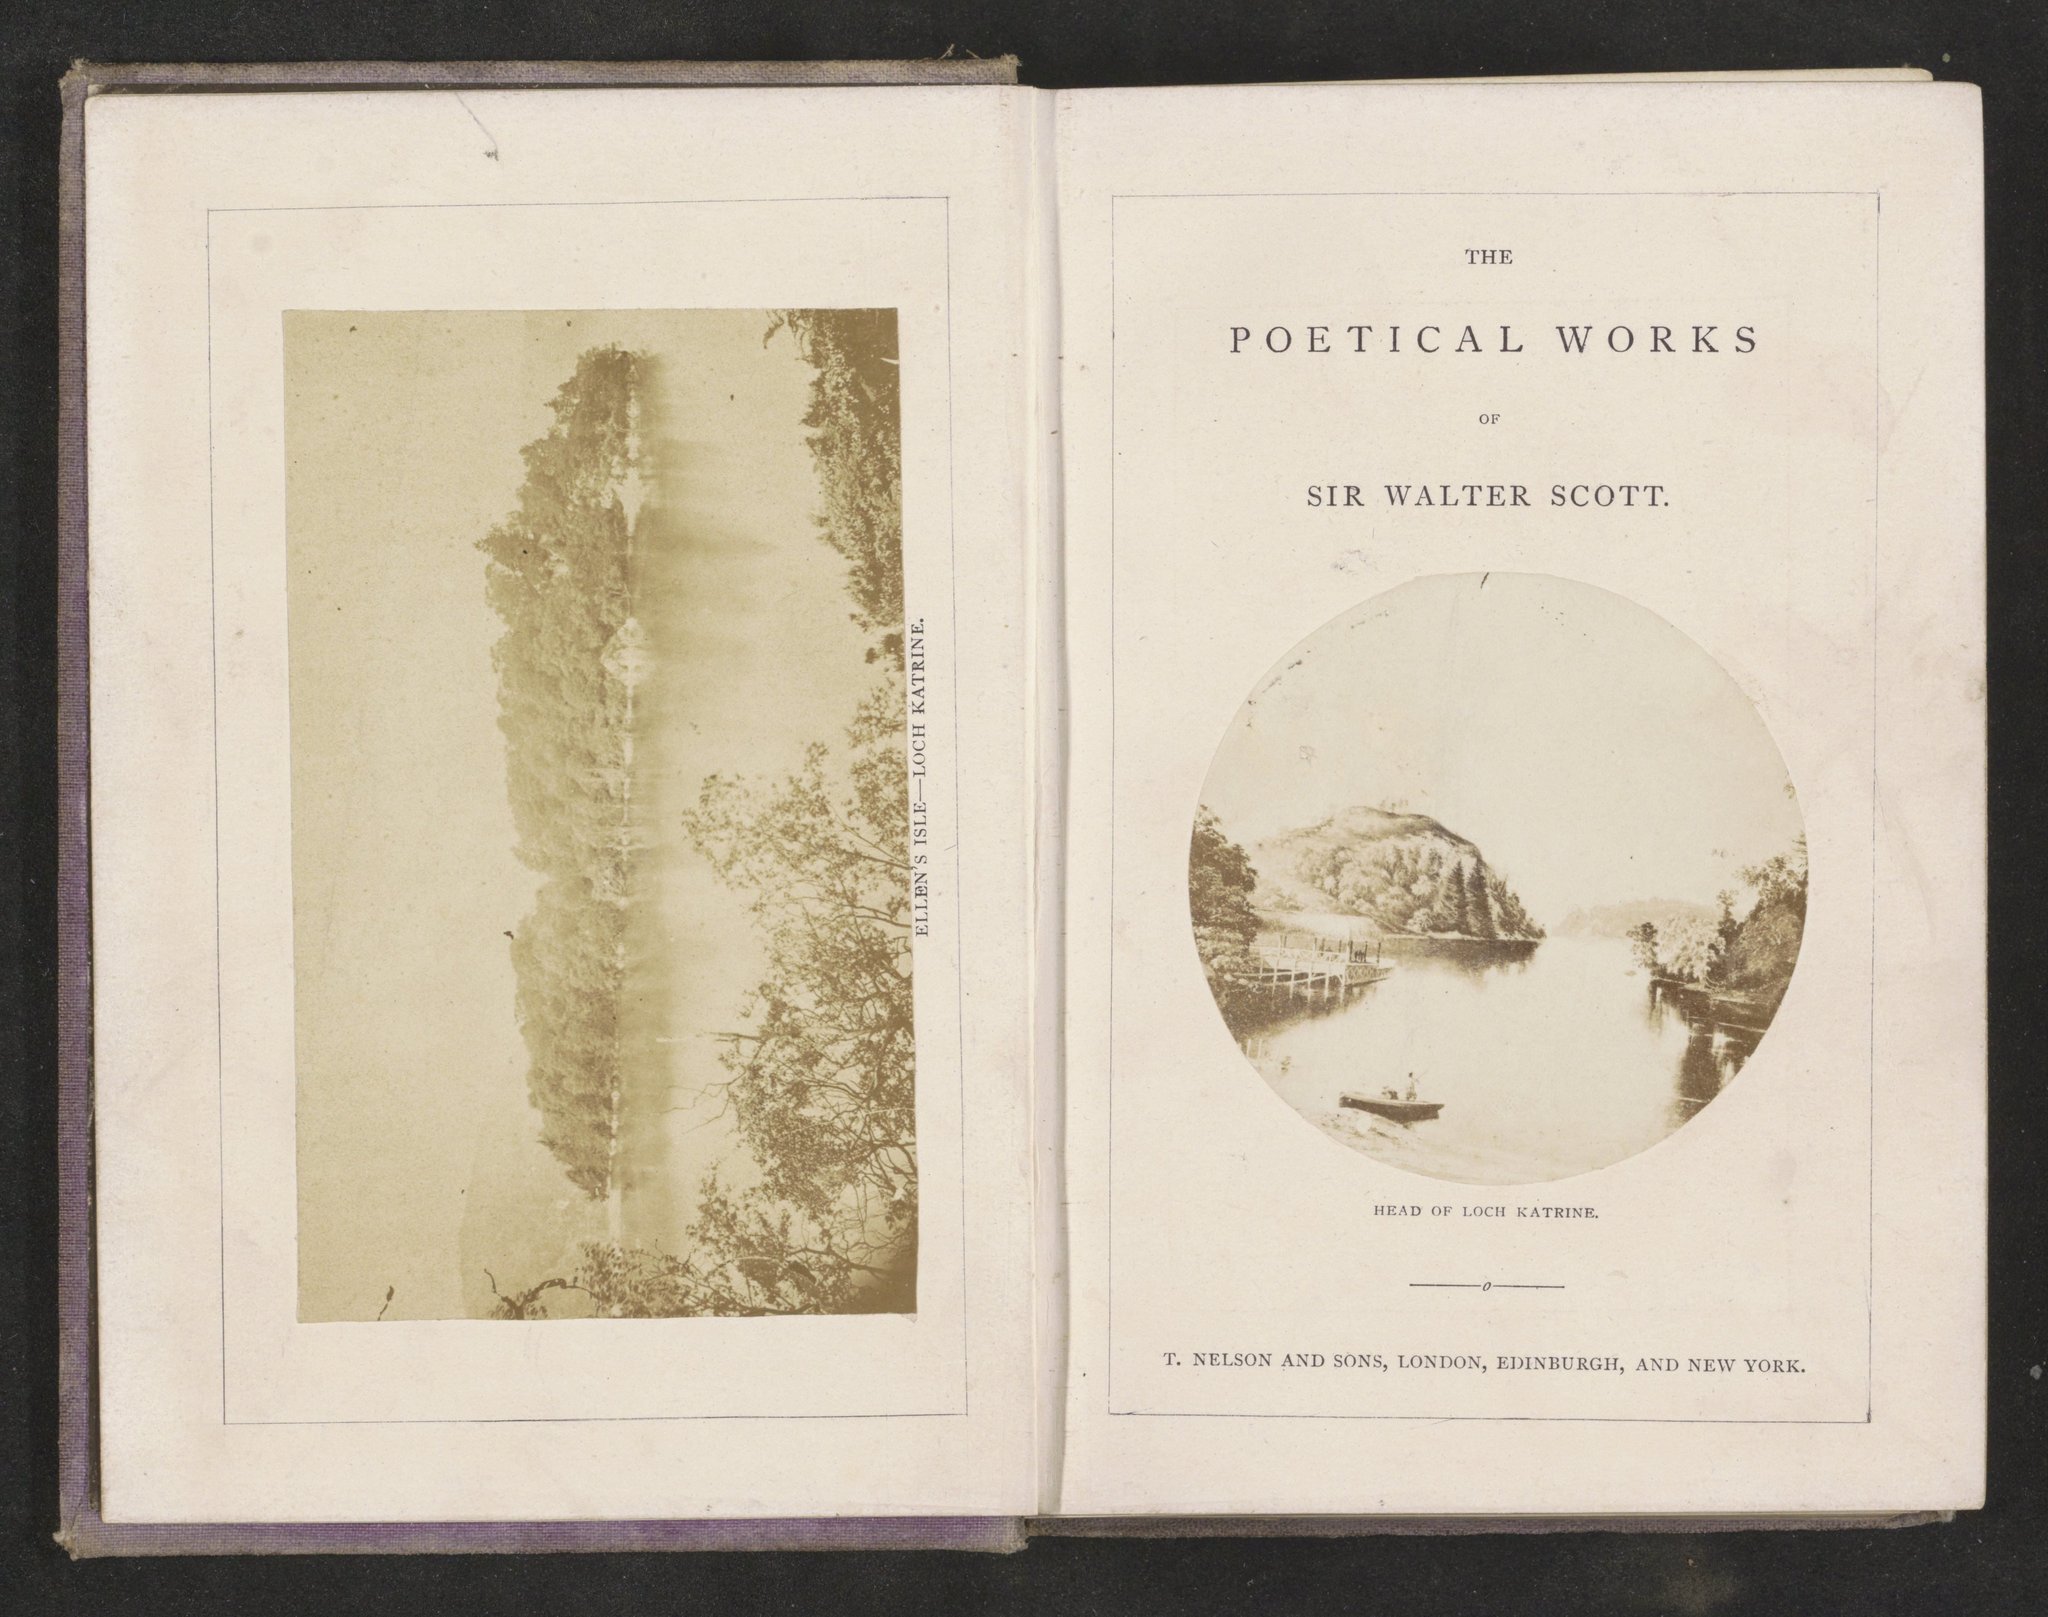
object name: photograph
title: Gezicht op Loch Katrine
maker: Anonymous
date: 1856-1866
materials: photographic support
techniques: albumen print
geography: stirling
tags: lake